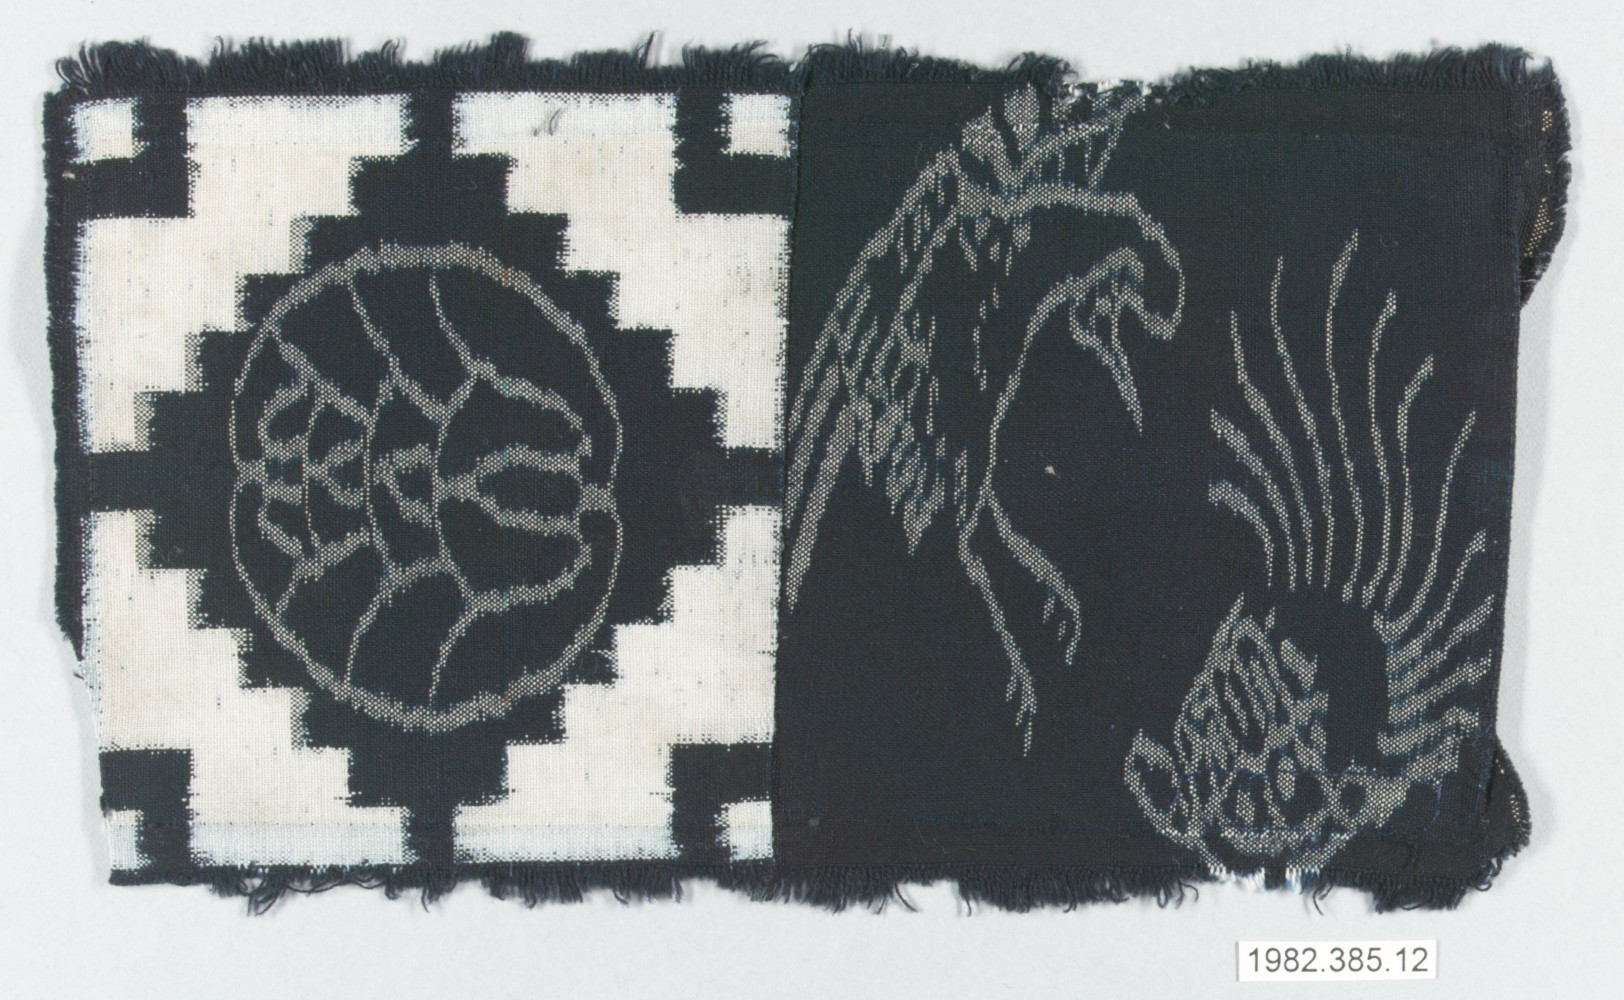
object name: piece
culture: japanese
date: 1868-1926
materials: cotton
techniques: dyeing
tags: birds